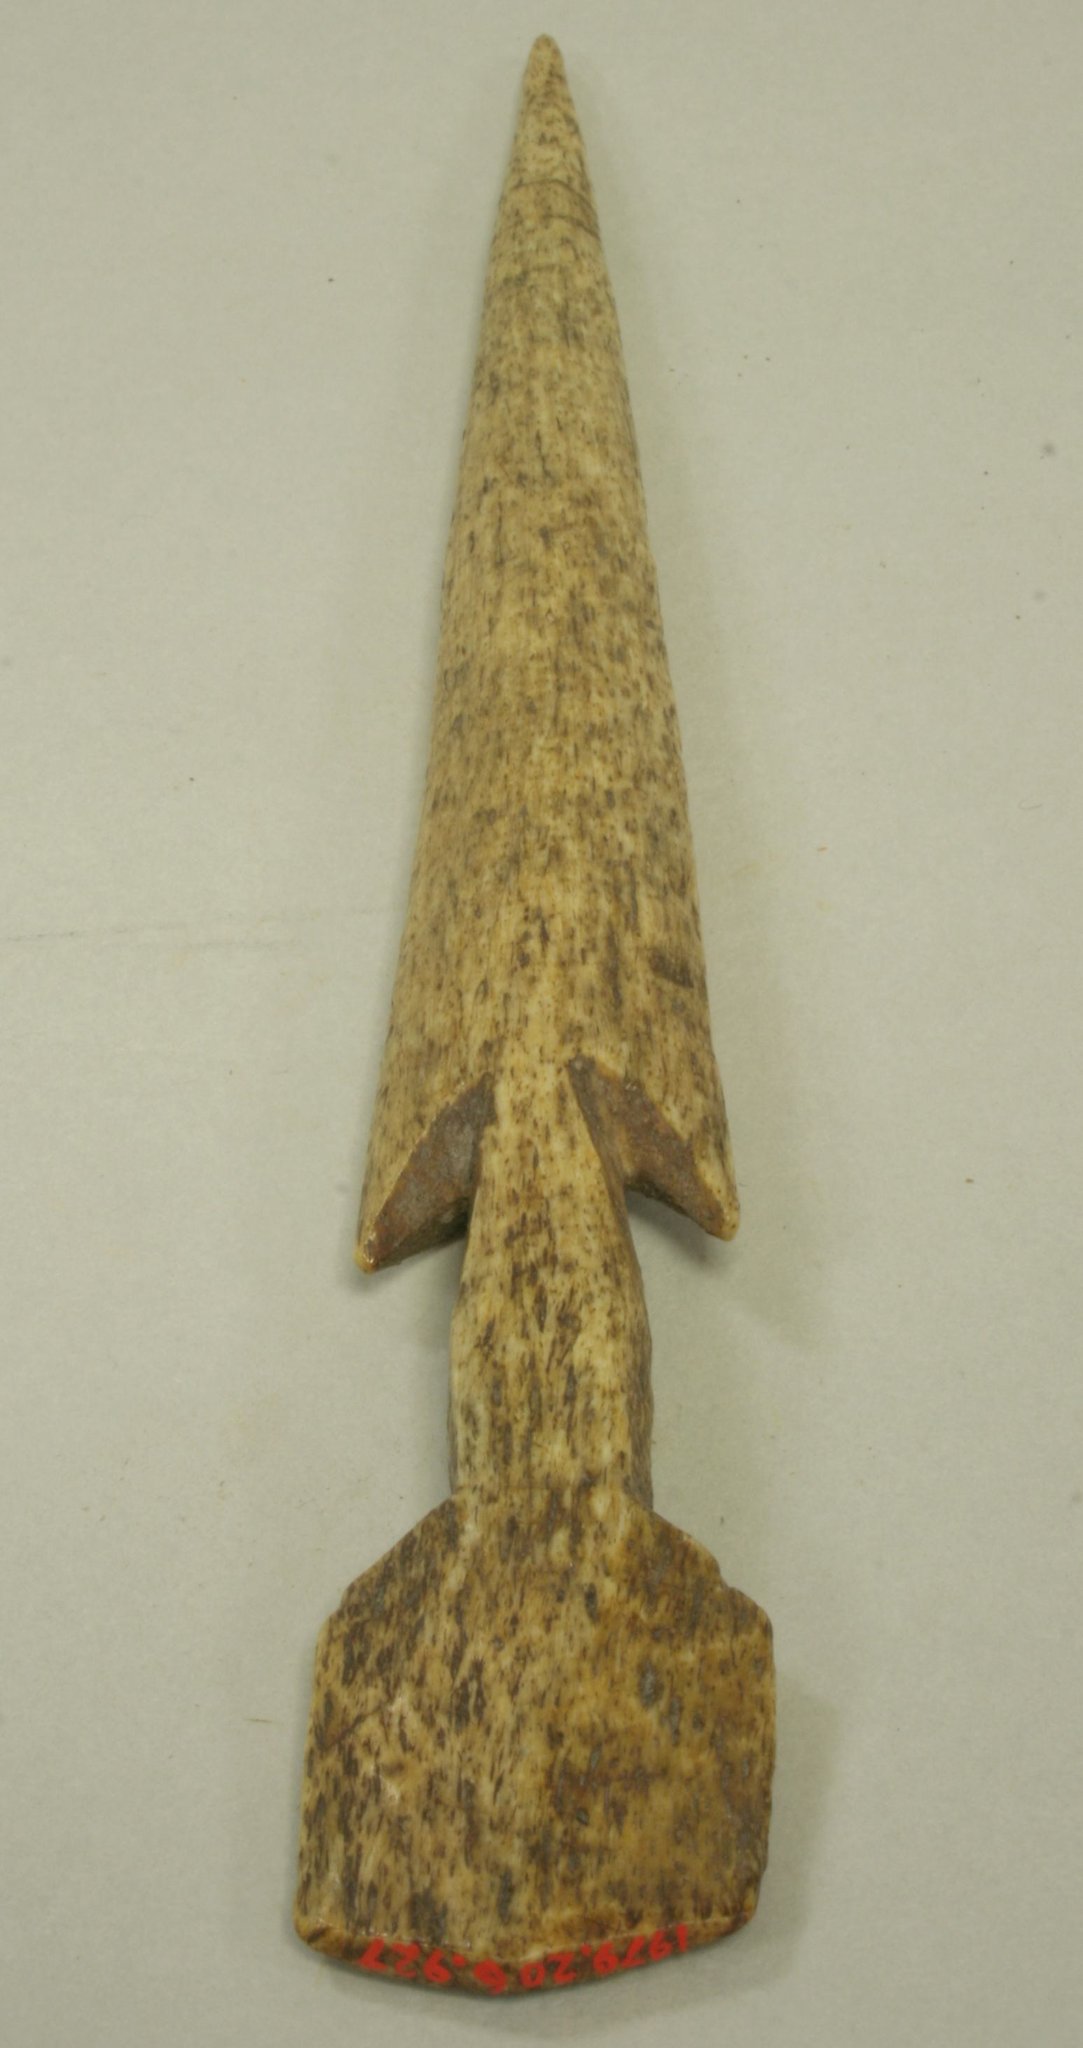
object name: spear head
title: Lance Head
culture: tierra del fuego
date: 301-1600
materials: ivory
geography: argentina